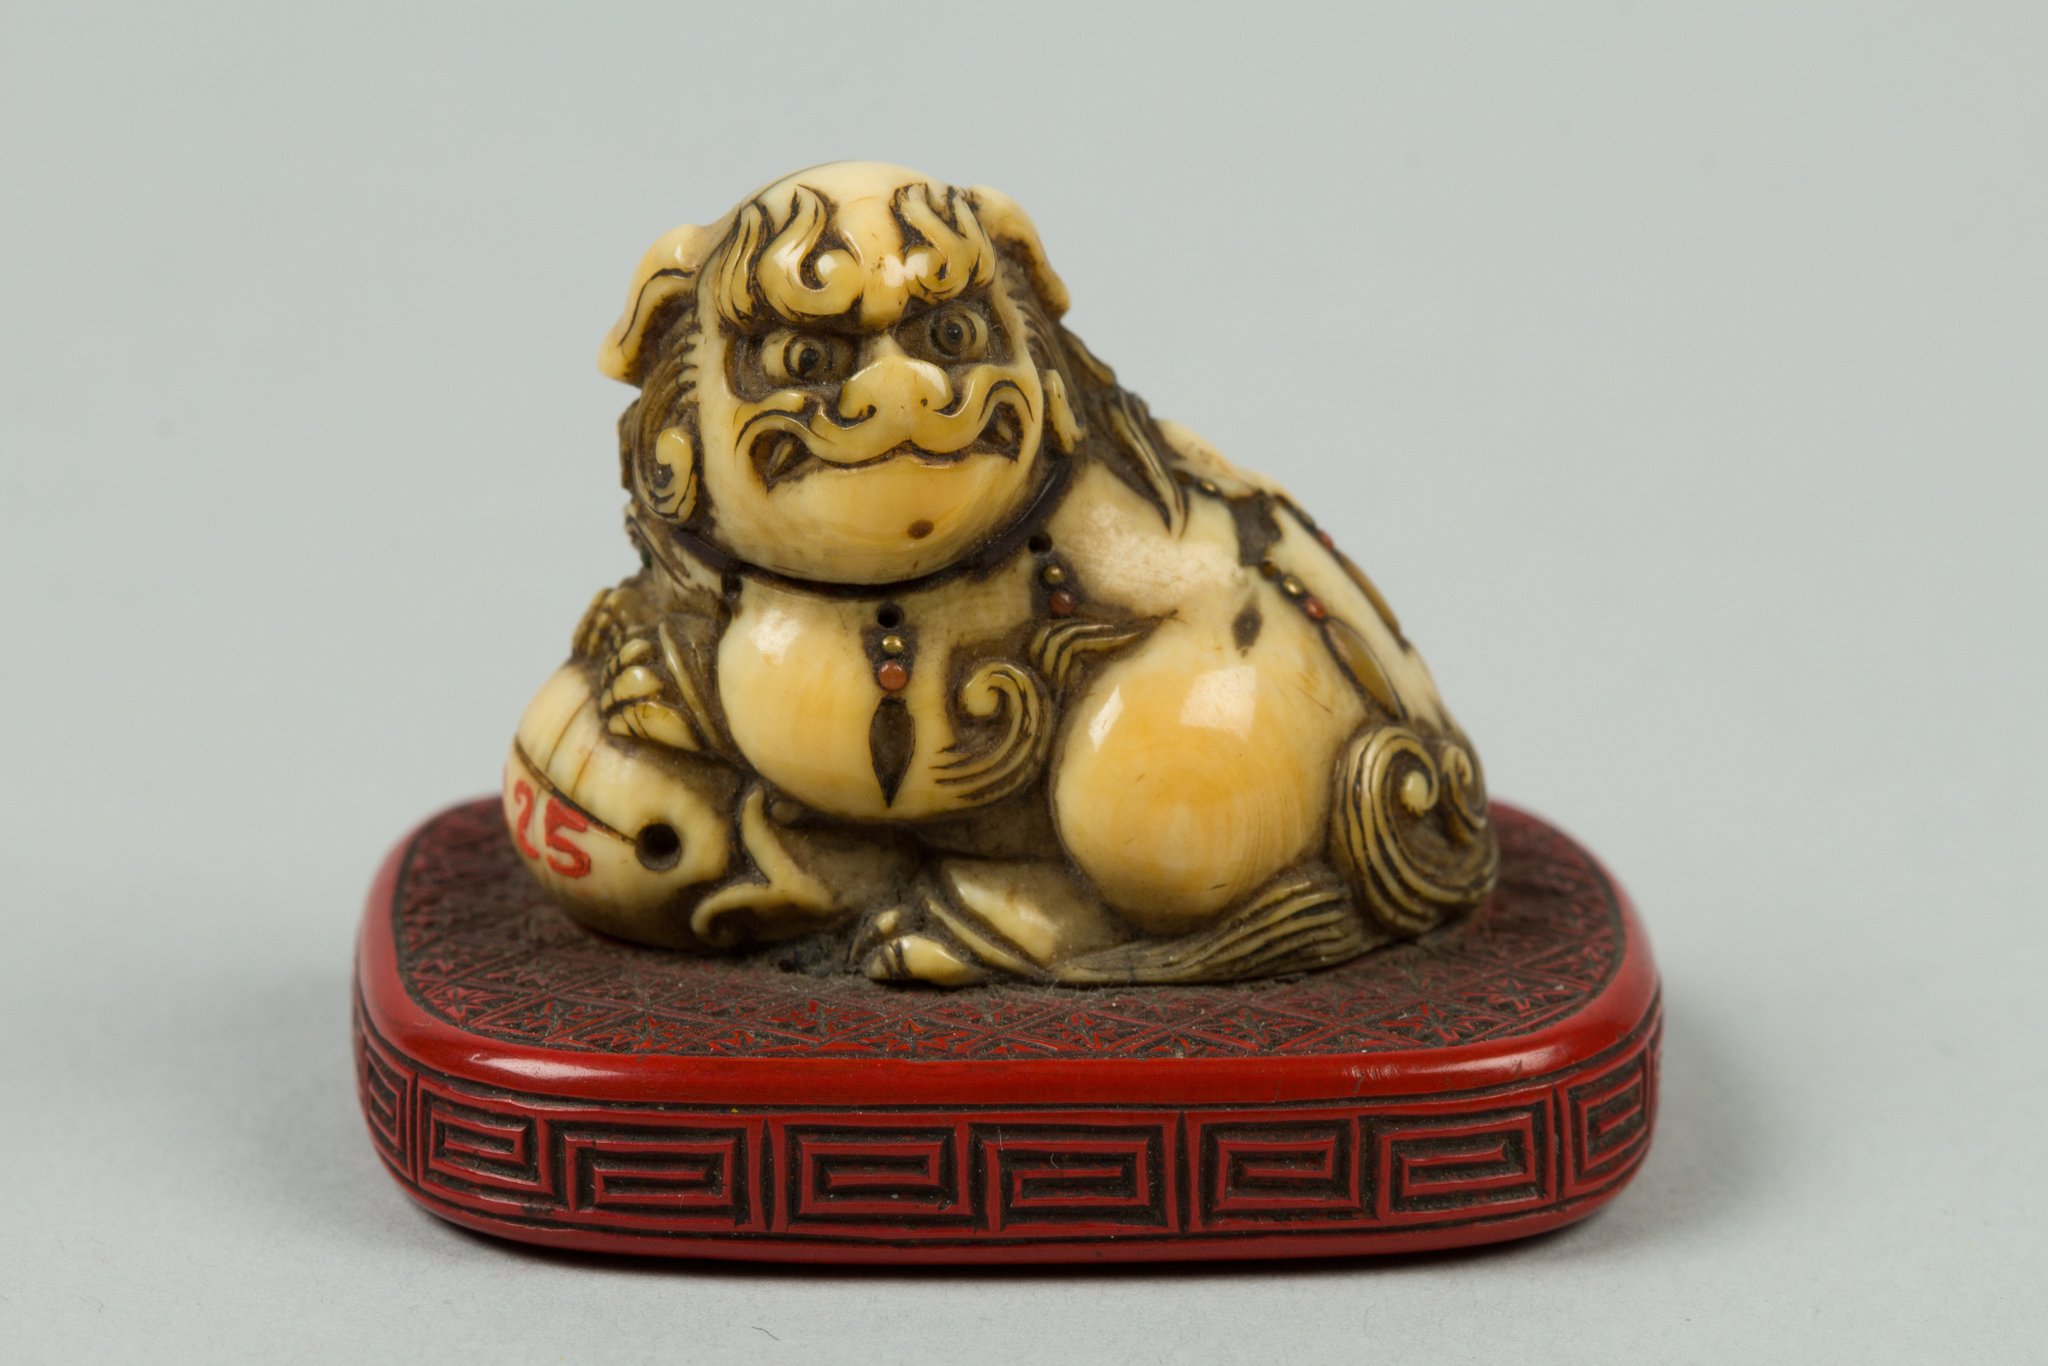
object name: netsuke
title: Netsuke of Qilin Sitting on a Nest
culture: japanese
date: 1801-1900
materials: ivory, lacquer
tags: mythical creatures